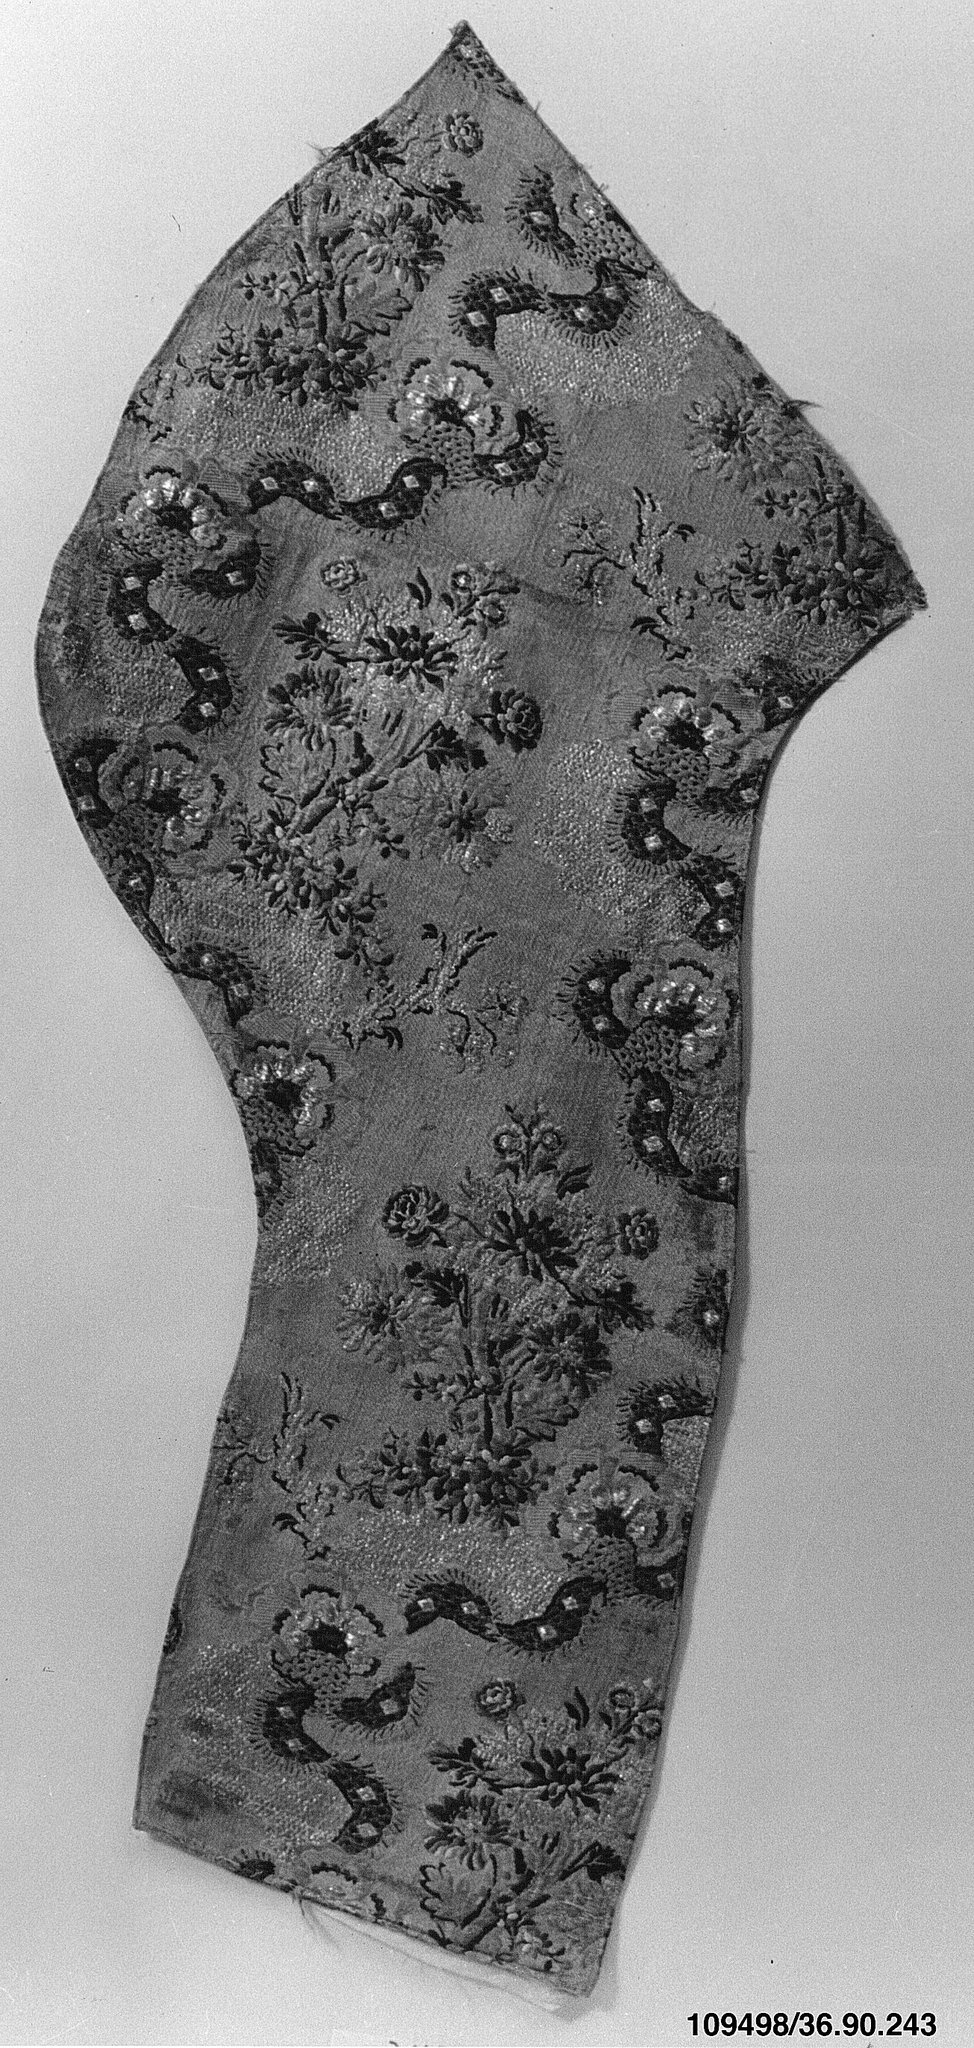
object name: piece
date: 1760-1770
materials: metal thread, silk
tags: flowers,leaves